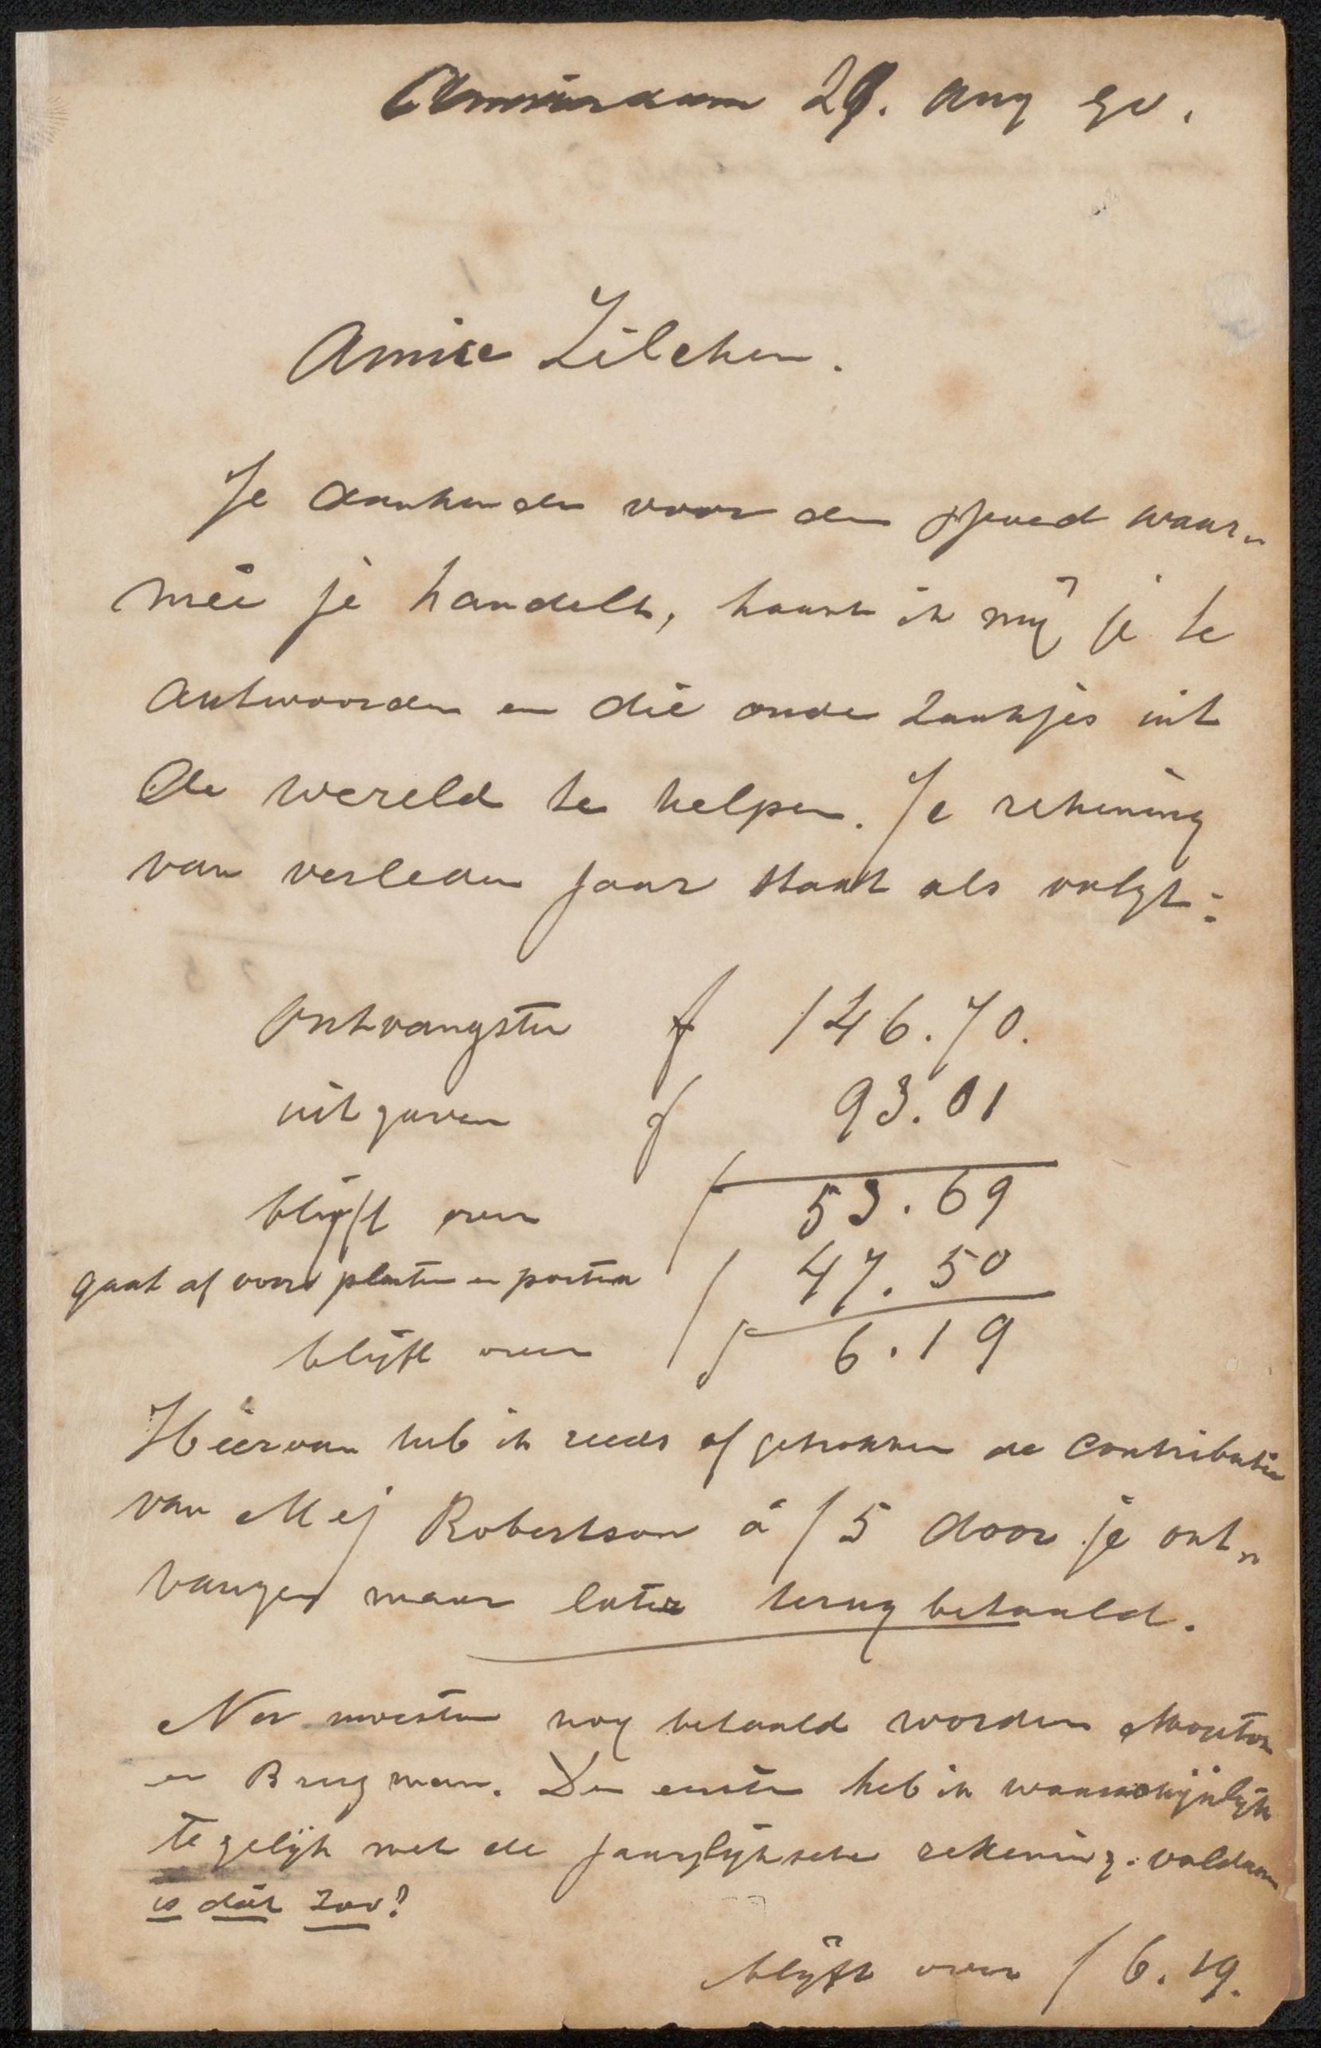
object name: letter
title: Brief aan Philip Zilcken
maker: eduard karsen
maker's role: draughtsman, painter, print maker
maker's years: 1860-1941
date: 1890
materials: ink, paper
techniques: pen, writing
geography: amsterdam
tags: painter, draughtsman, suze robertson, philip zilcken, the graphic arts, money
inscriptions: collector's mark: ‘RPK’